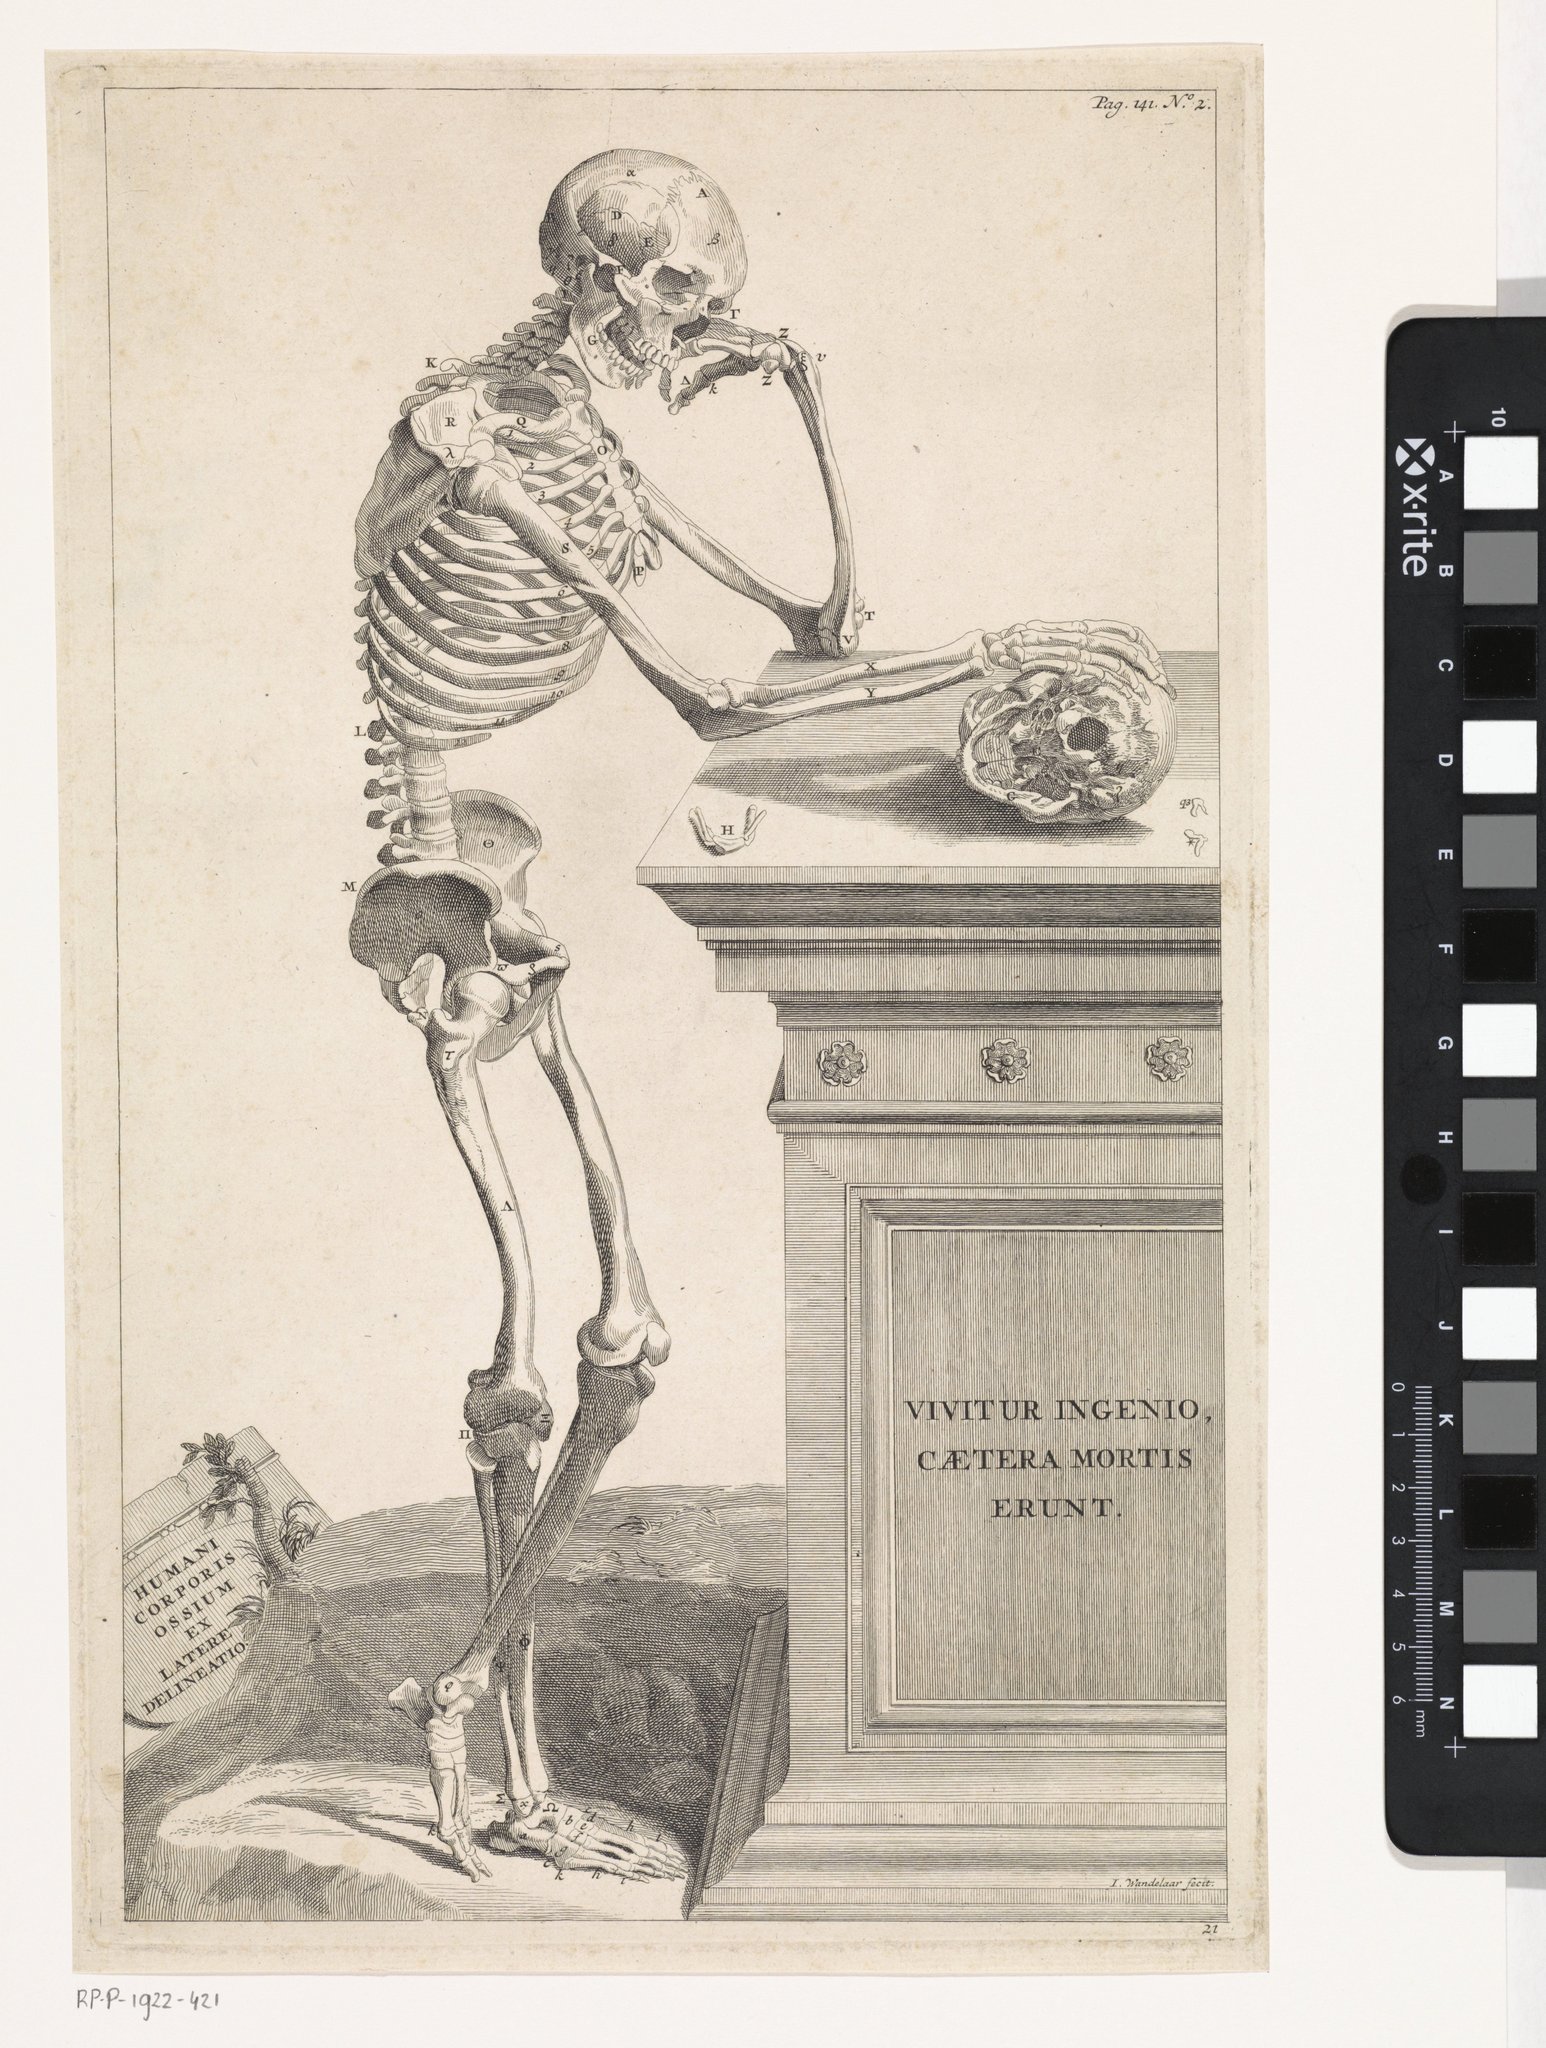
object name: book illustration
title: Skelet naast monument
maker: jan wandelaar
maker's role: draughtsman, print maker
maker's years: 1690-1759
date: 1725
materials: paper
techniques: engraving, etching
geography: northern netherlands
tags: (human) skeleton (+ sideview, profile)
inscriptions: collector's mark: Lugt 2233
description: Prent gebruikt als illustratie in: Vesalius, Andreas. [Bewerkt door] Herman Boerhaave en Bernhard Siegfried Albinus. Opera omnia anatomica & chirurgica, p. 141. Leiden: Johannes Du Vivié, Johannes en Hermanus Verbeek, 1725.